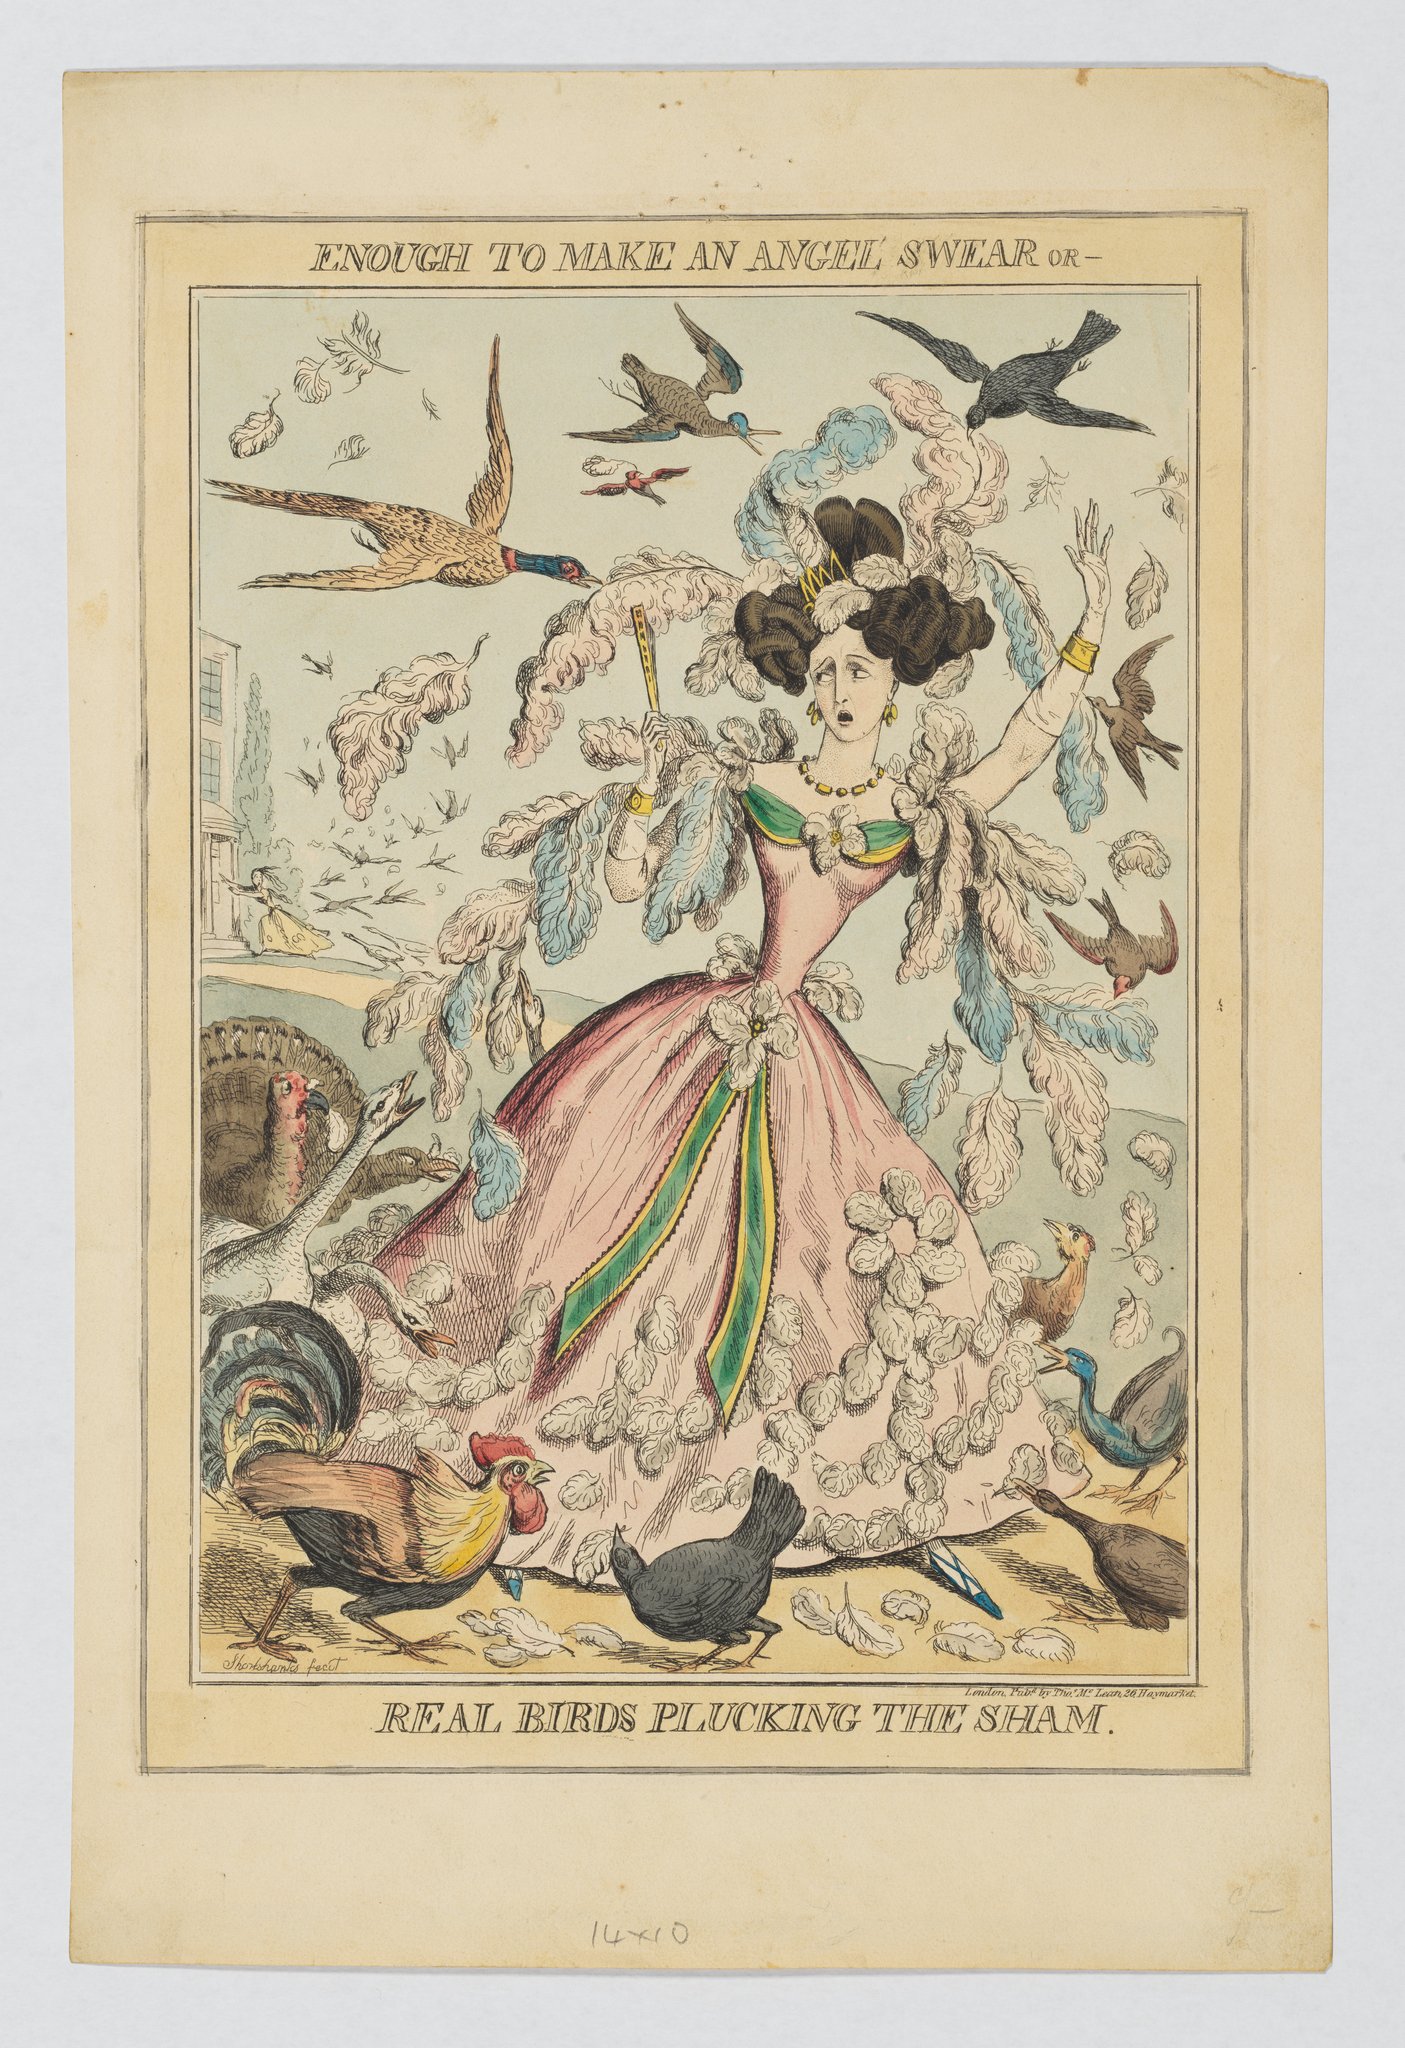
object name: print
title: Enough to Make an Angel Swear, or–Real Birds Plucking the Sham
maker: robert seymour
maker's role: artist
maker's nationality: british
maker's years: 1798-1836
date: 1828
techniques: etching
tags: birds,women,roosters,turkeys